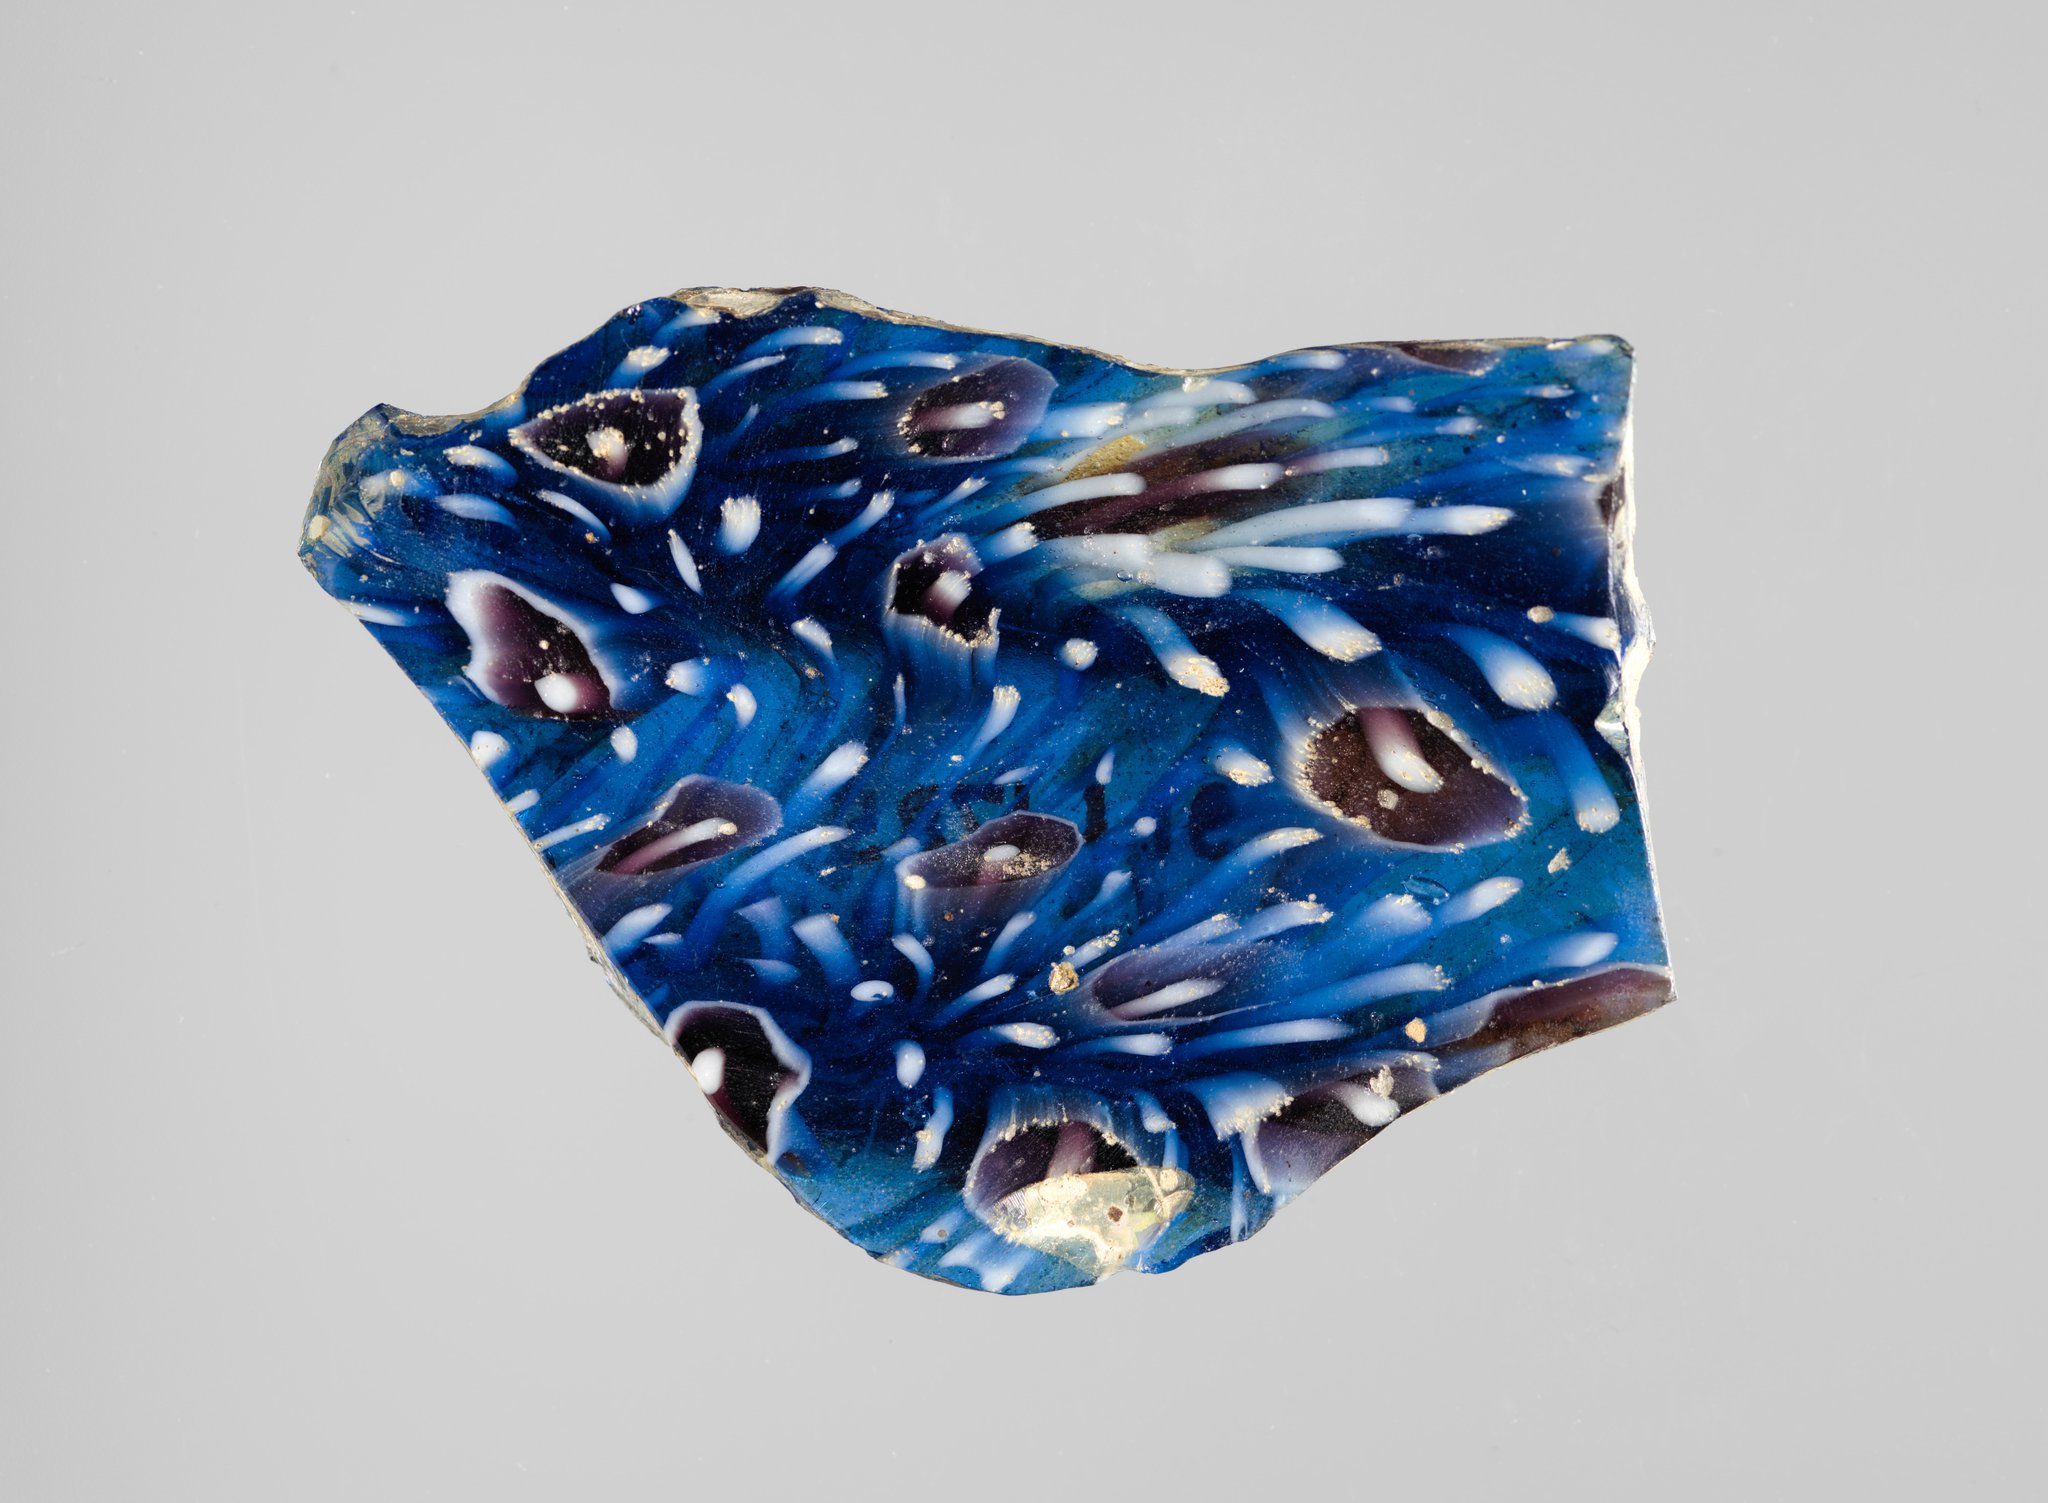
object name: fragment, mosaic bowl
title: Glass mosaic ribbed bowl fragment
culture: roman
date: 34 BCE-33 CE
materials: glass